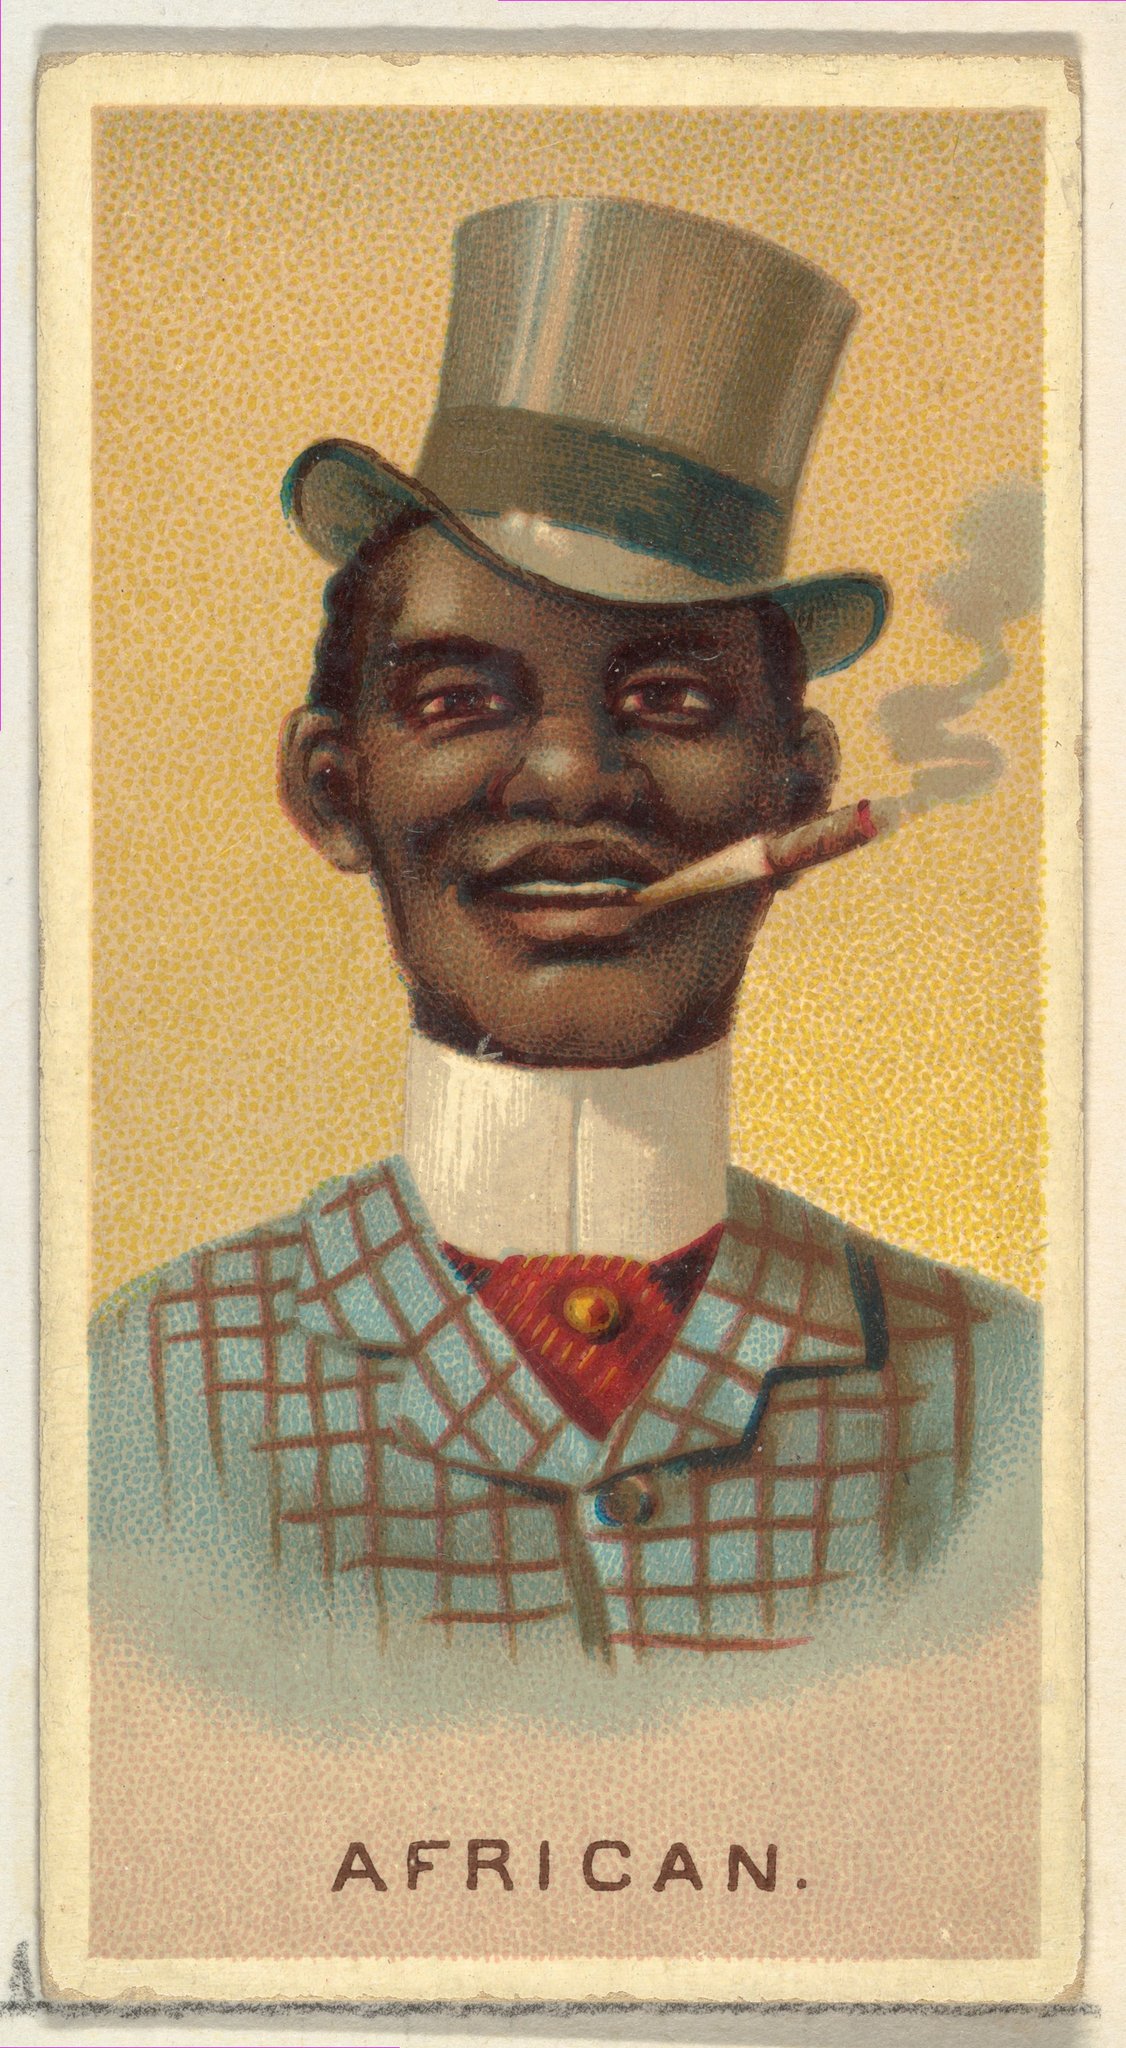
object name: print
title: Caricature of an African man, from World's Smokers series (N33) for Allen & Ginter Cigarettes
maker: allen & ginter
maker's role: publisher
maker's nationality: american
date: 1888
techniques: color lithograph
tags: men,smoking